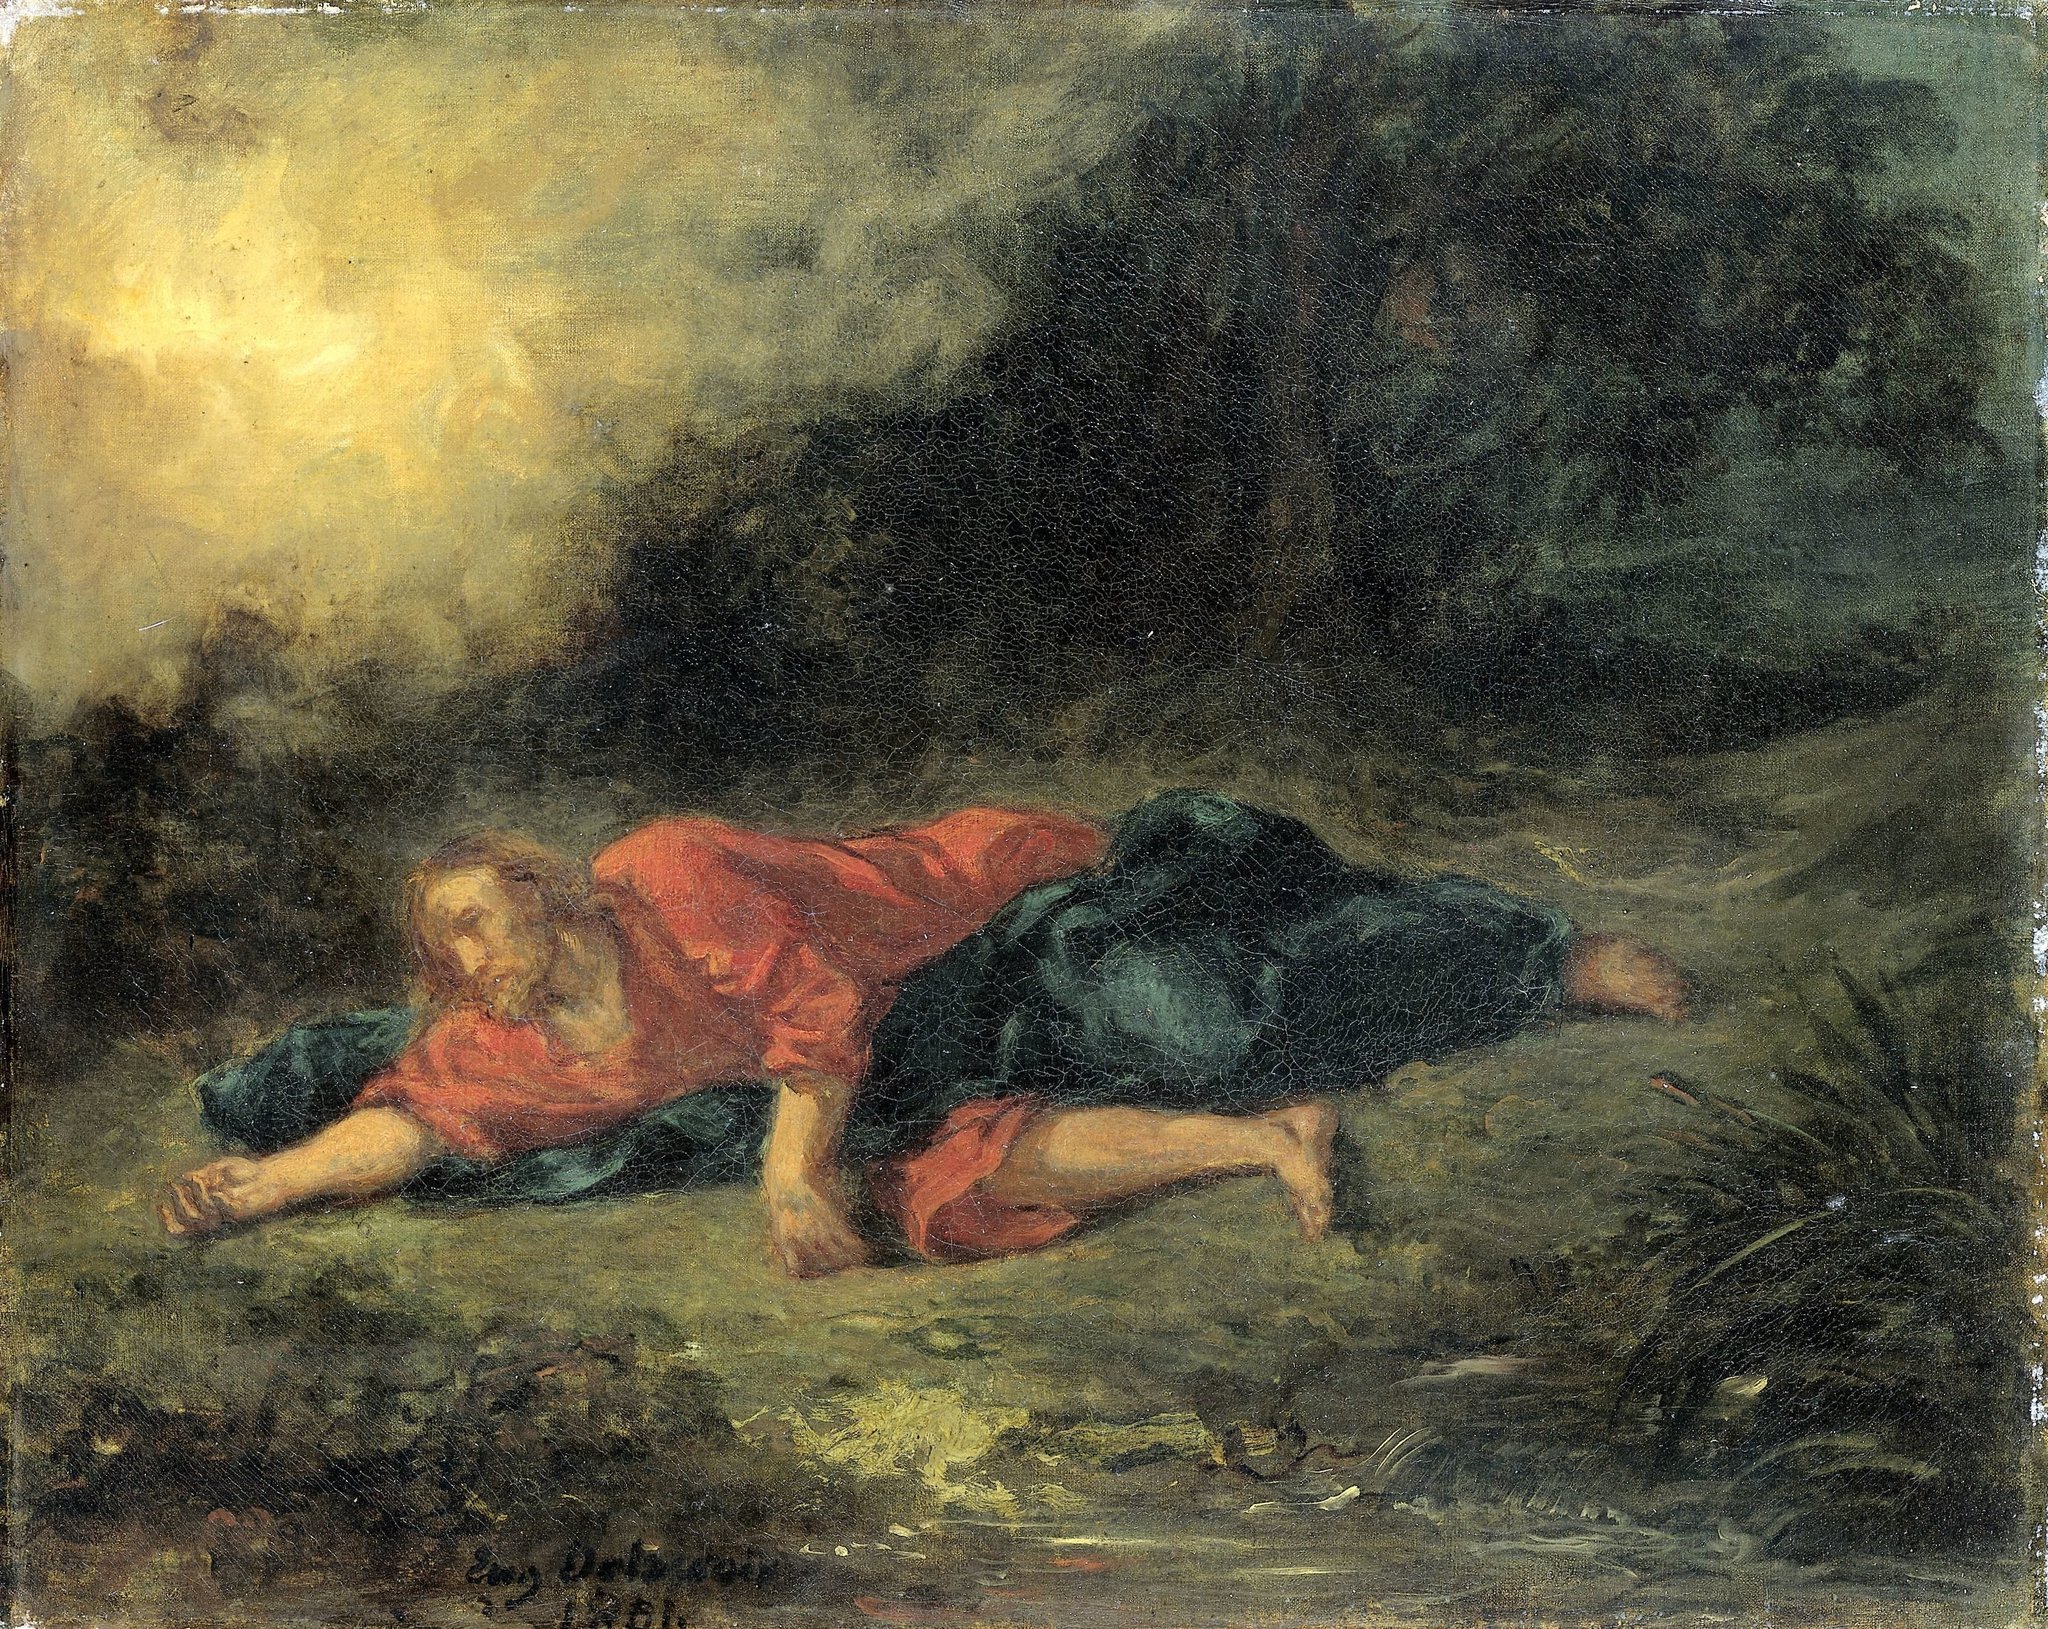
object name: painting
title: The Agony in the Garden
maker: eugène delacroix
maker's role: draughtsman, print maker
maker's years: 1798-1863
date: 1851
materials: canvas, oil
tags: christ's prayer in the garden of gethsemane during the night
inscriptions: signature and date: ‘Eug. Delacroix 1851’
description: Christus in Gethsemané. Christus ligt uitgestrekt op de grond, links een lichtschijnsel.